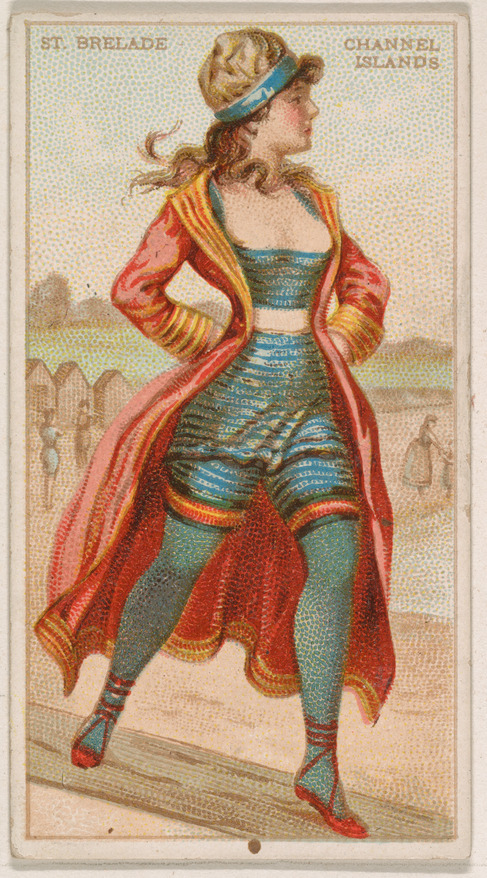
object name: print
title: St. Brelade, Channel Islands, from the Surf Beauties series (N232), issued by Kinney Bros.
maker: kinney brothers tobacco company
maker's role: publisher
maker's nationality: american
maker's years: 1869-2011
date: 1889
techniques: color lithograph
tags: profiles,women